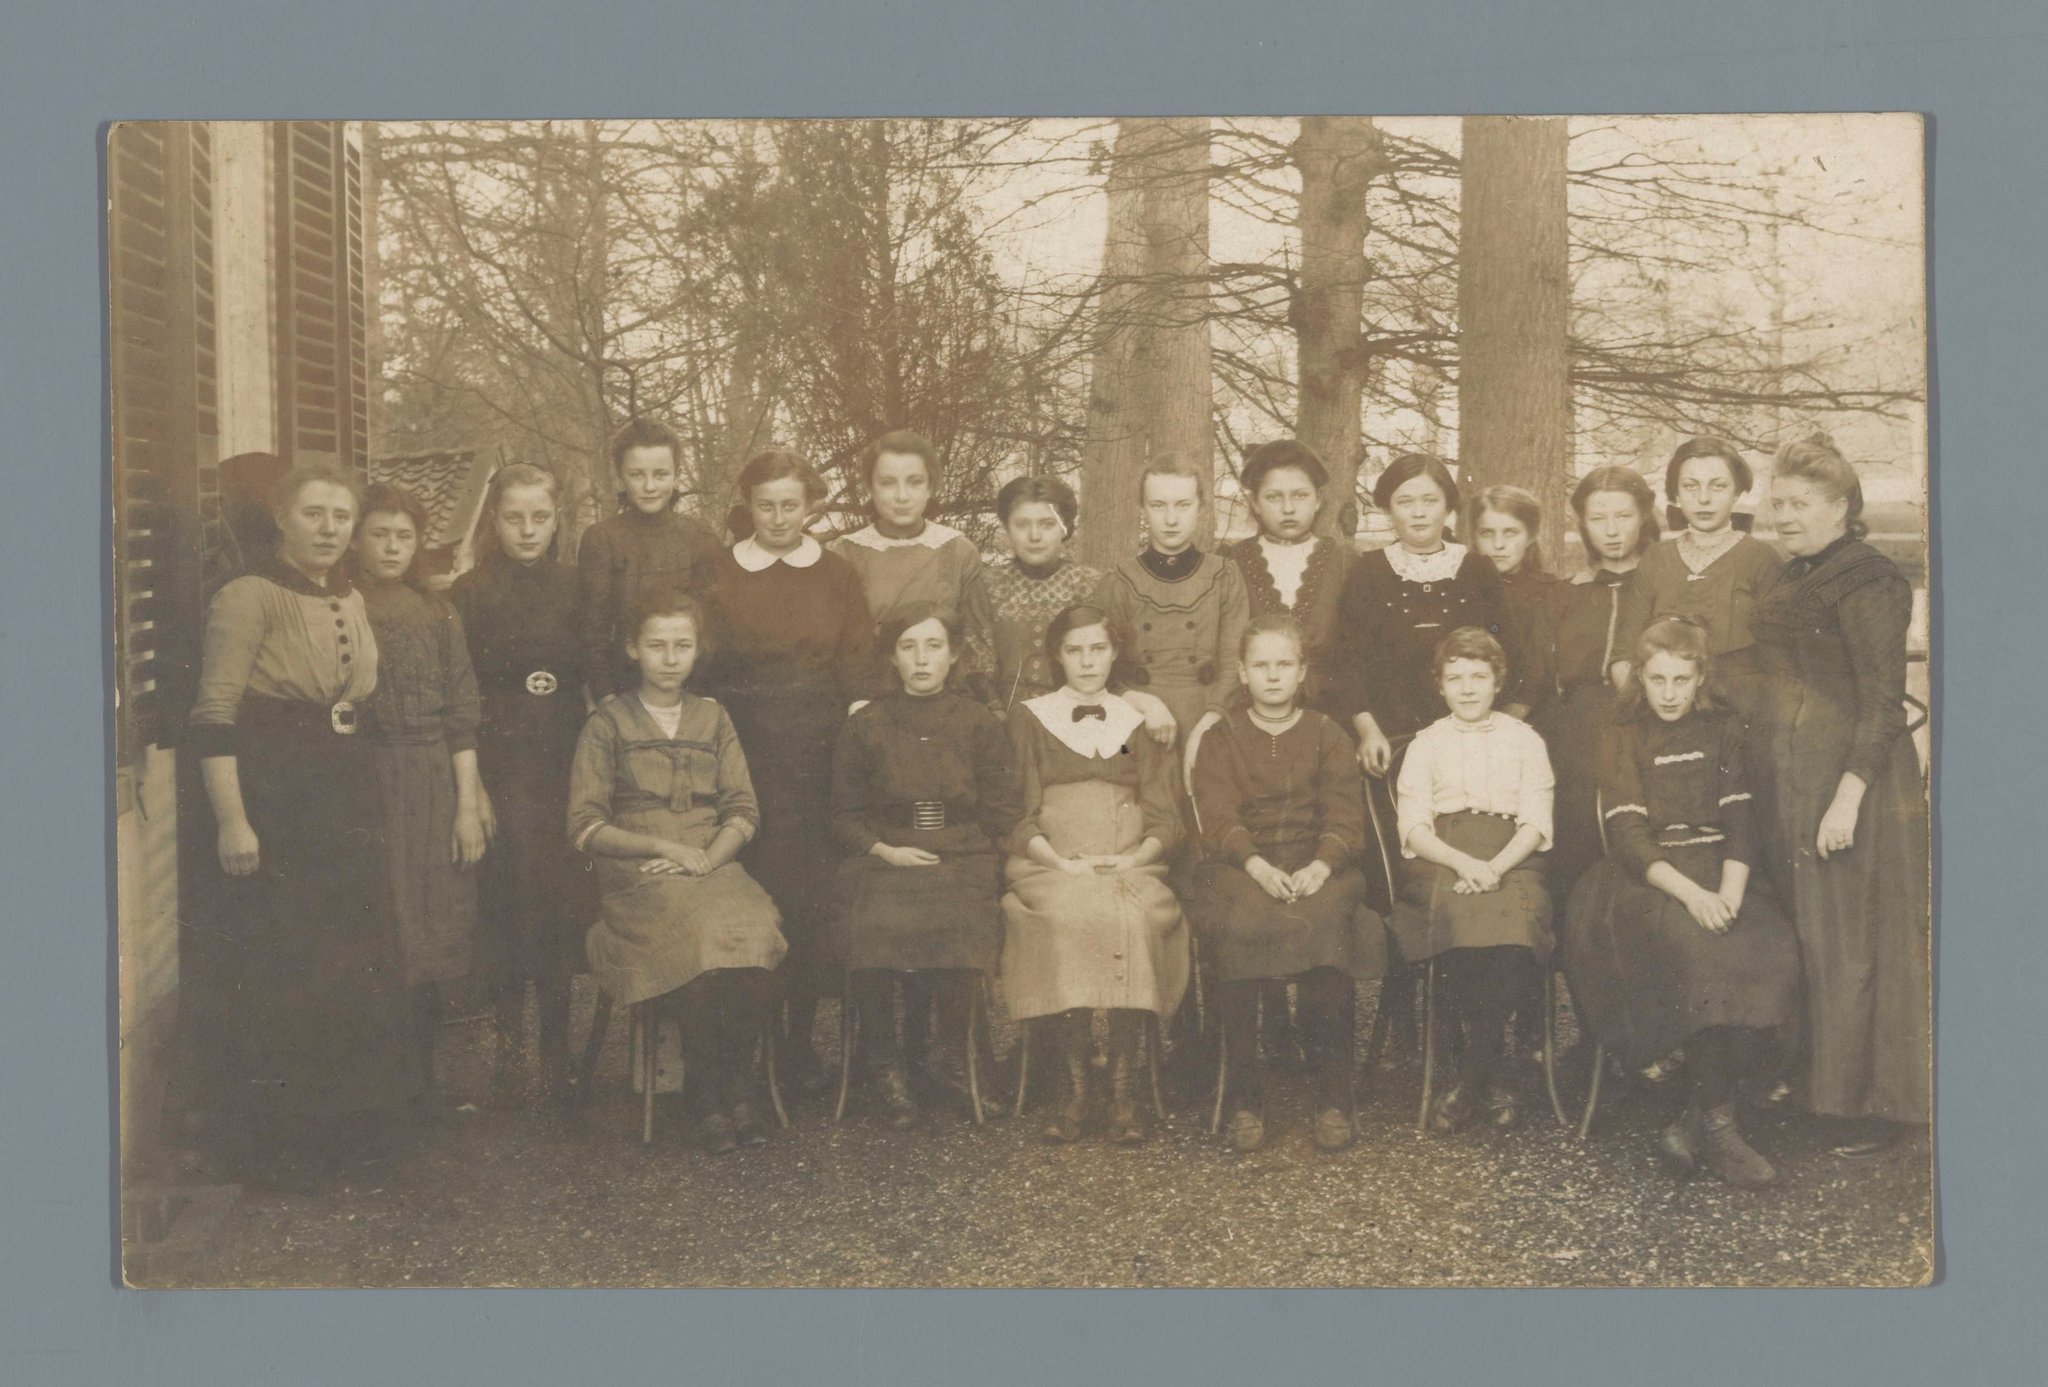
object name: photograph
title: Groepsportret van kinderen en onbekende vrouwen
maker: Anonymous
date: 1907-1915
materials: photographic support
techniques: gelatin silver print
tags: child, anonymous historical persons portrayed in a group, in a group-portrait